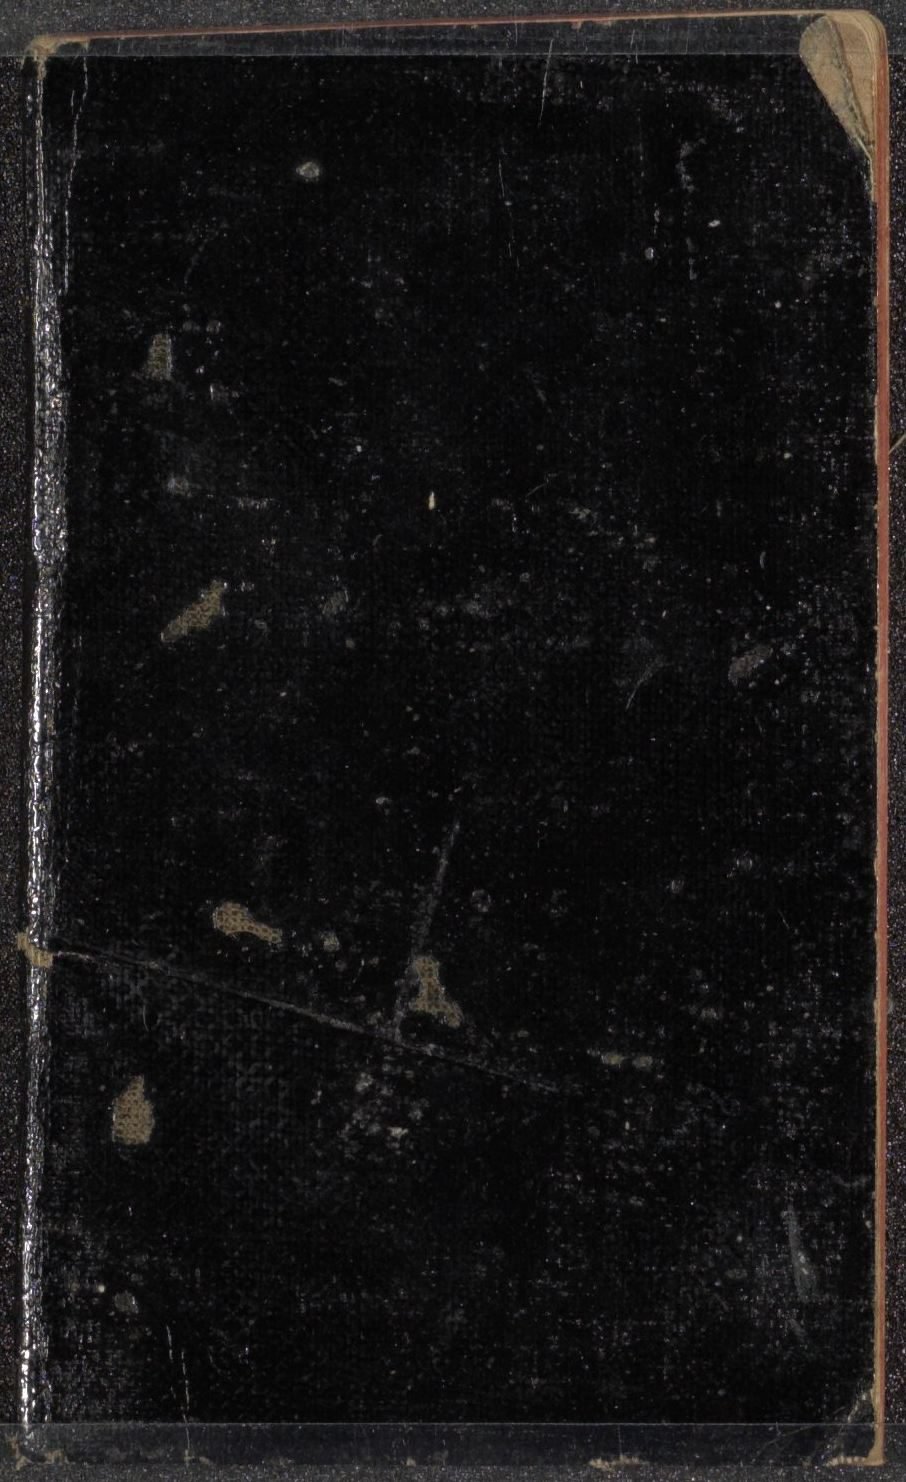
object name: sketchbook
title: Schetsboek met 29 bladen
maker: george hendrik breitner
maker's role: draughtsman, painter, print maker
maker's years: 1857-1923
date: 1896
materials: cardboard, chalk, linen, pencil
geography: amsterdam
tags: street, amsterdam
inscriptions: collector's mark: Lugt 2228, workshop stamp: Lugt 291d, date: ‘1896’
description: Schetsboek bestaande uit 29 bladen, waarvan 8 betekend met gezichten te Amsterdam.